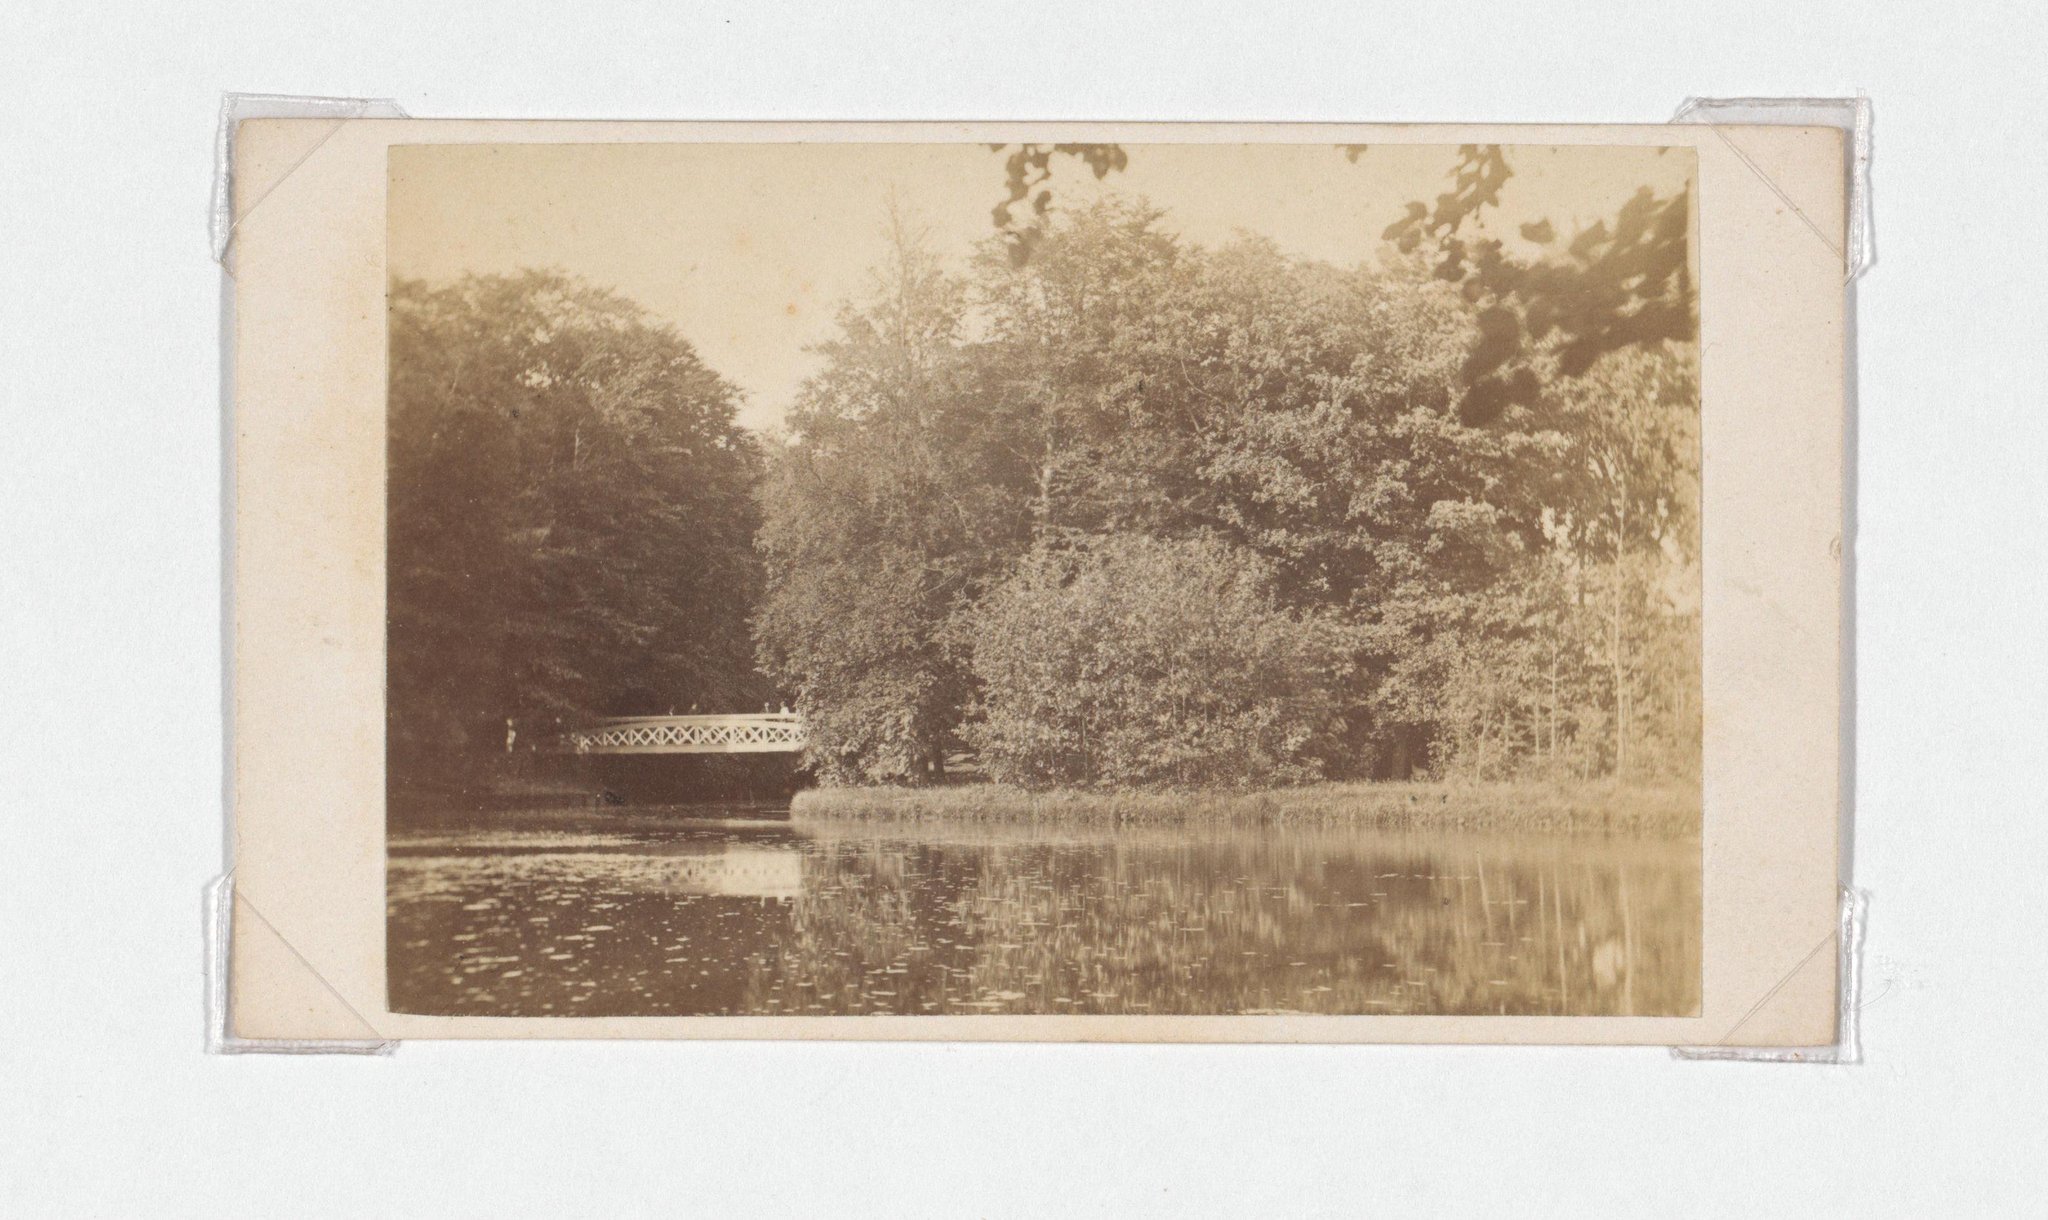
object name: photograph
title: Gezicht op een brug over een water, mogelijk in een park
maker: andries jager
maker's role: publisher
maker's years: 1825-1905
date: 1860-1880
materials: cardboard, paper, photographic support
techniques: albumen print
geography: amsterdam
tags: public gardens, park, amsterdam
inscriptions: address: ‘Water 110 Amsterdam’